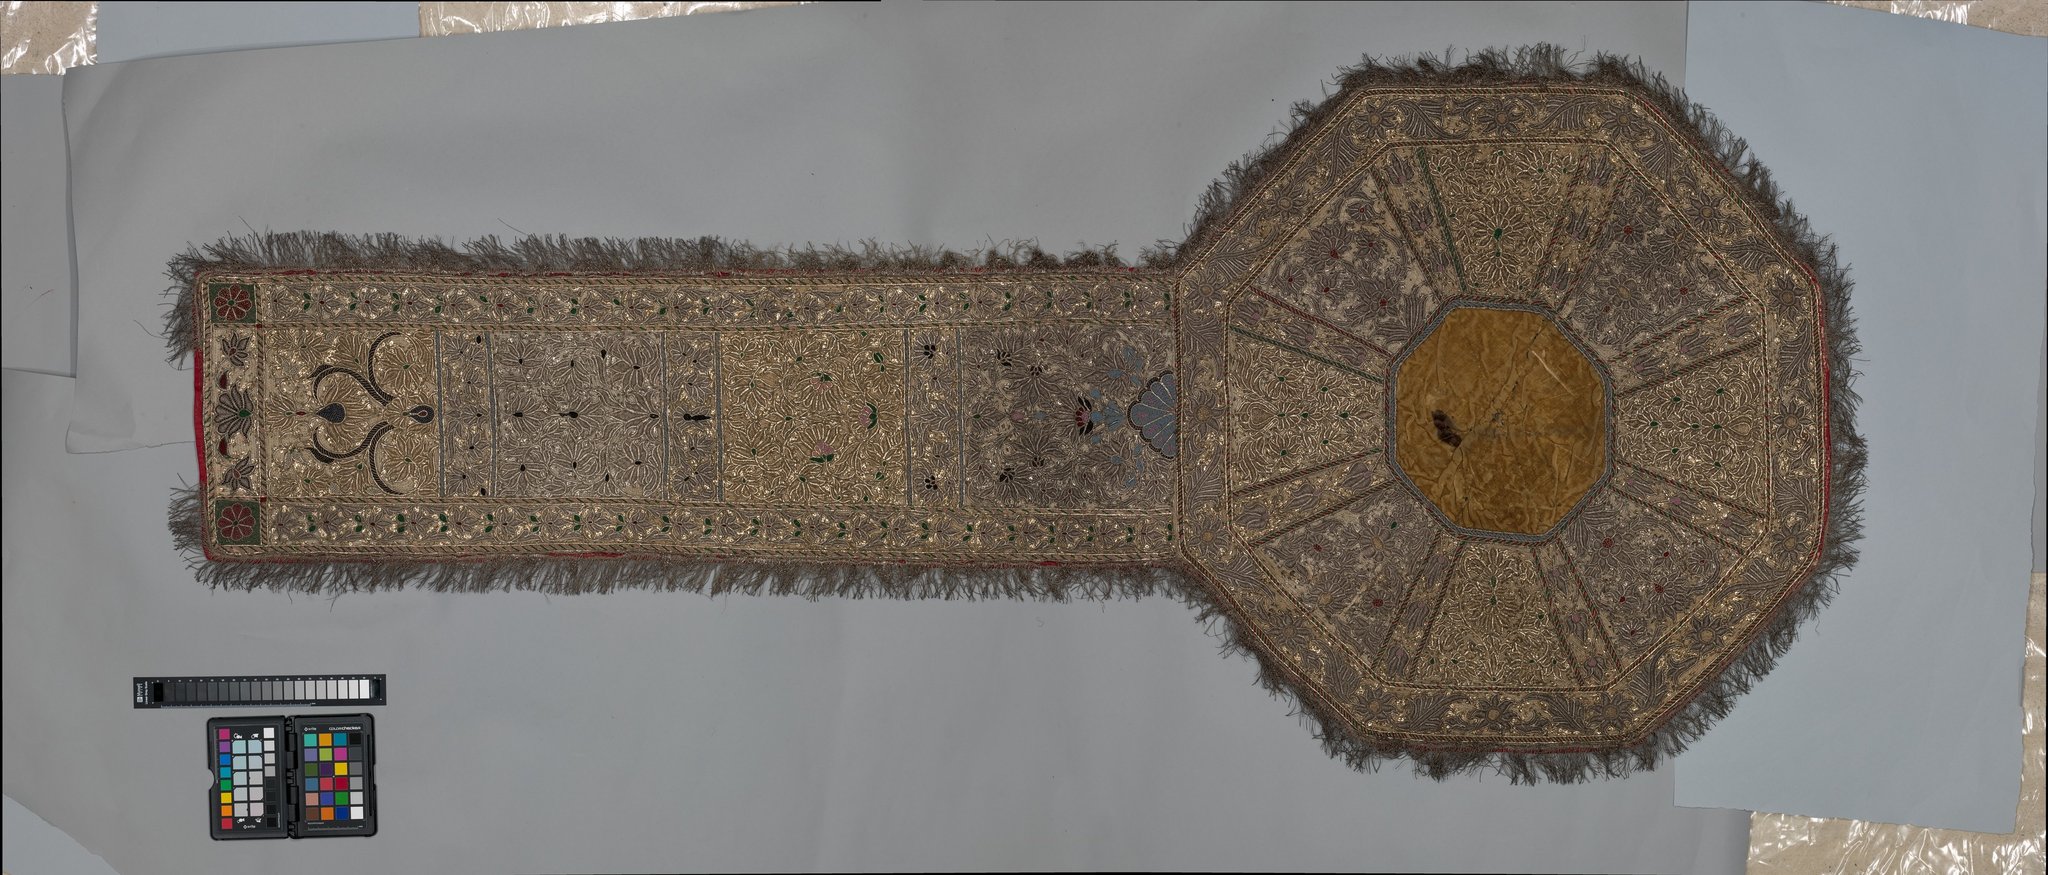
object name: huqqa mat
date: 1800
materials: canvas, cotton, metal thread, silk, velvet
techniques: embroidery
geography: india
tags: hookah